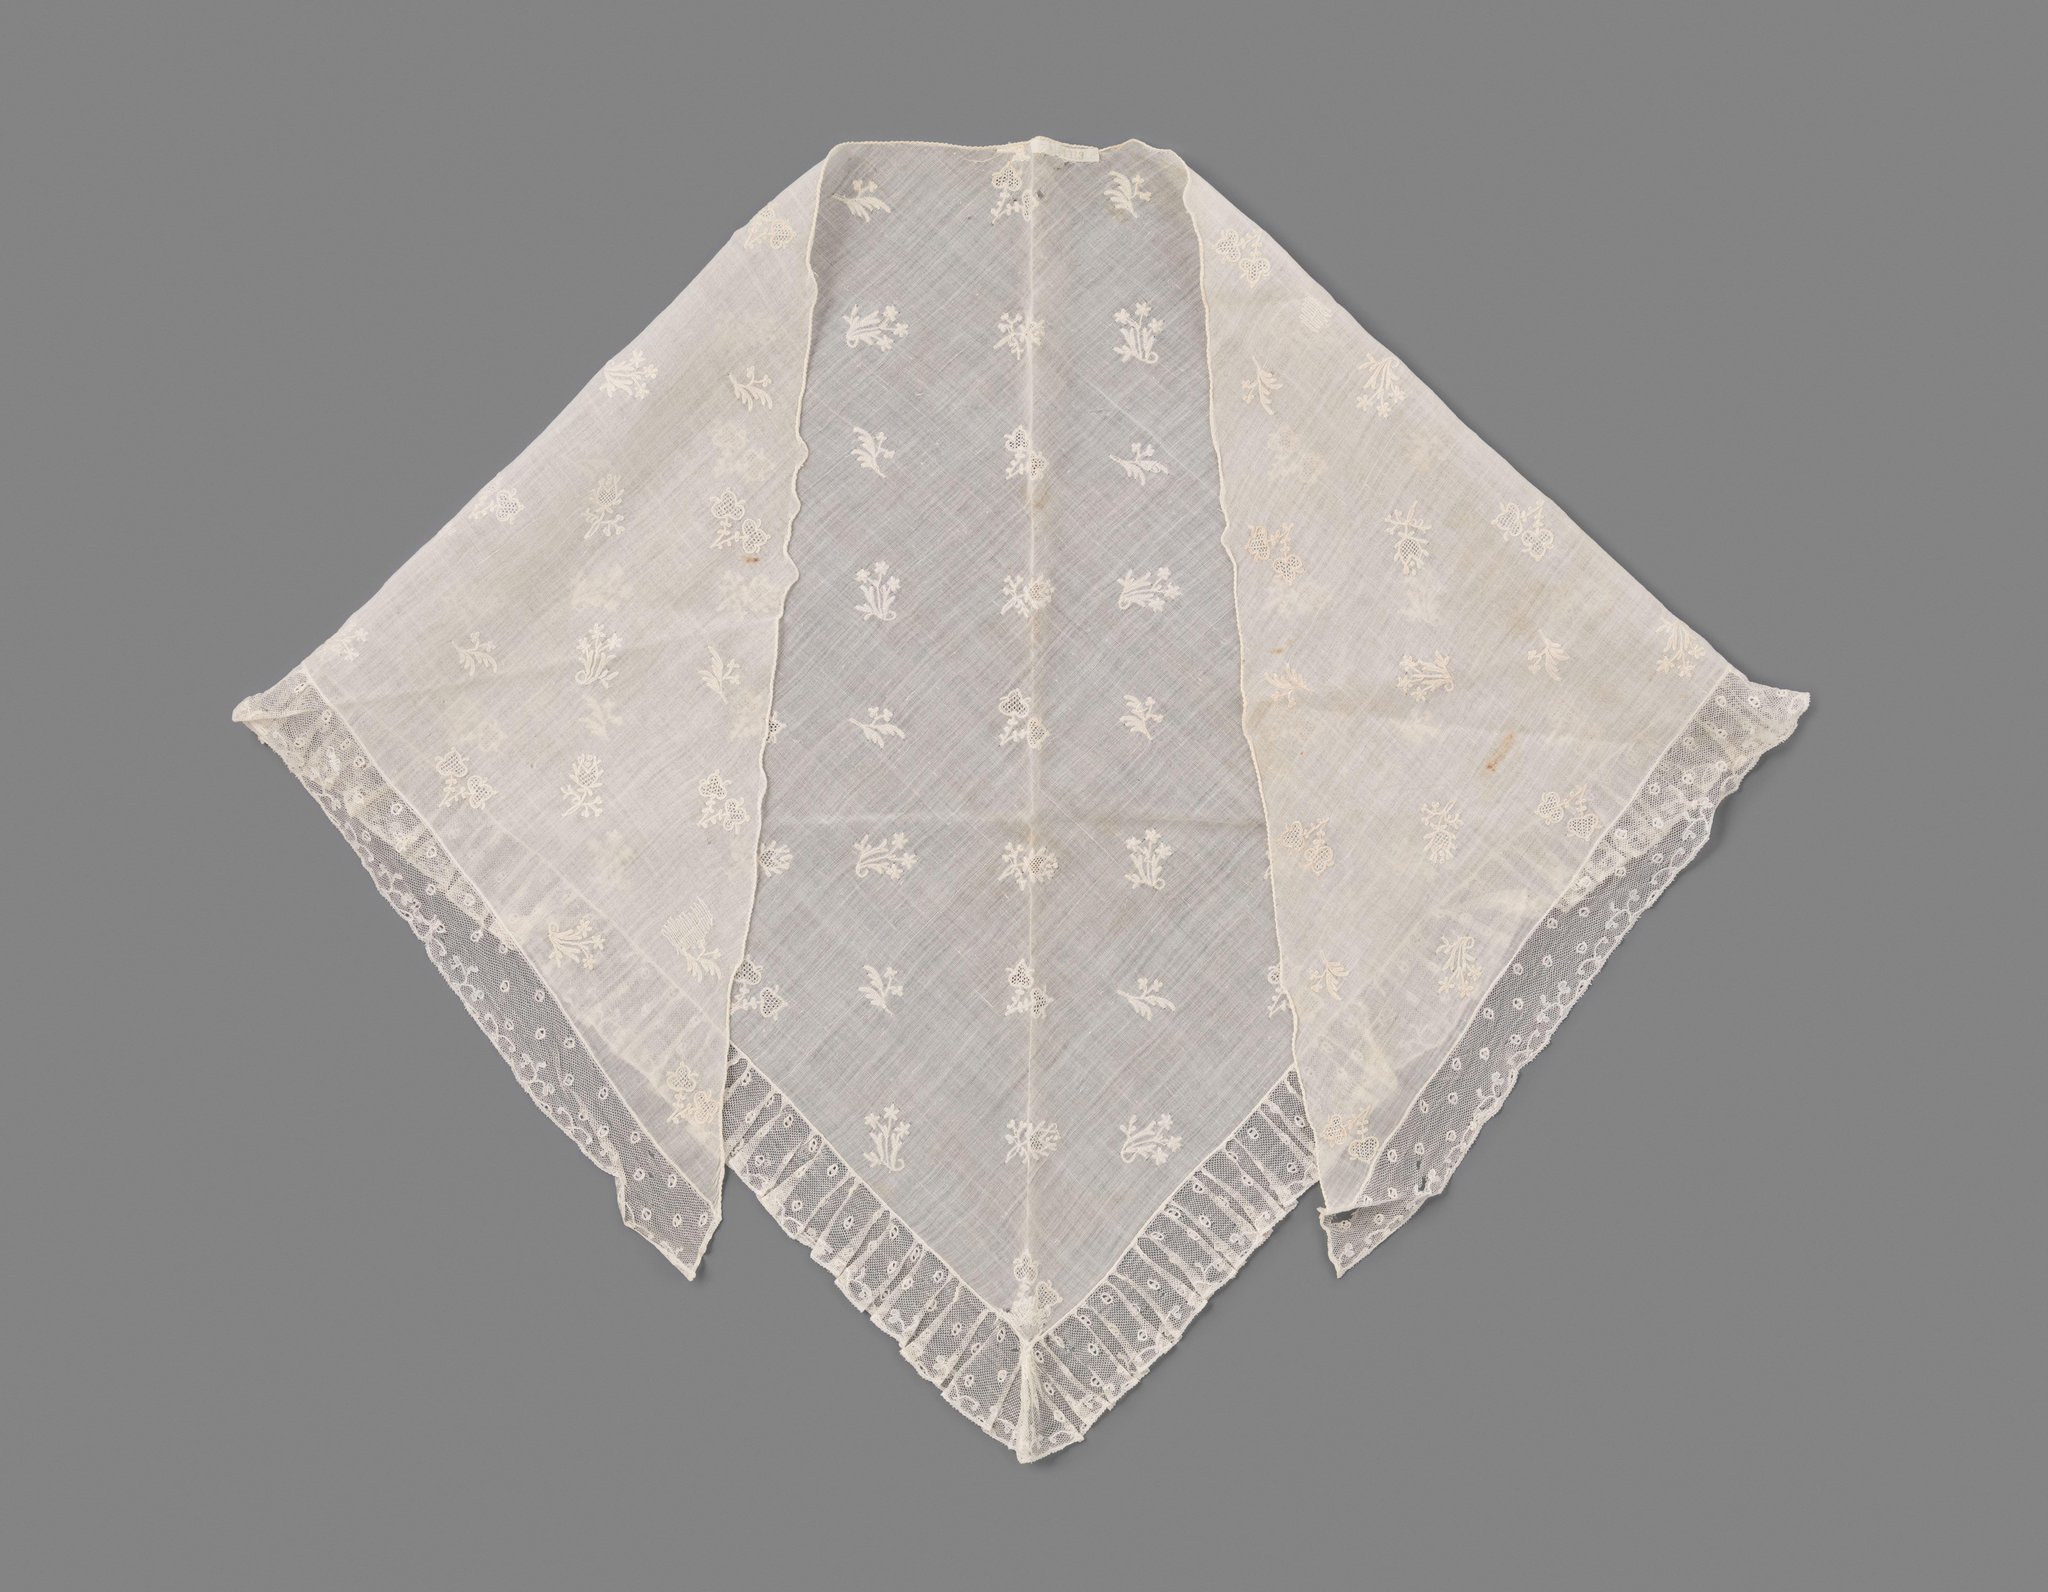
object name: fichu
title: Fichu van linnenbatist, driekantig, getamboereerd met strooiboeketten van katoen en langs twee zijden afgezet met een gedeeltelijk gerimpelde strook Mechelse kant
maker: Anonymous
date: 1775-1800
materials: cotton, linen, silk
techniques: cockled, lace, weave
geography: zaanstreek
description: Fichu van linnenbatist, driekantig, getamboereerd met strooiboeketten van katoen en langs twee zijden afgezet met een gerimpelde strook Mechels kloskant. Versiering: strooimotief van fantasiebloemen en boeketten, waarvan sommige met naaldkant harten. De strook kloskant is voor de helft gerimpeld (op de rug) en waar de fichu aan de voorkant afhangt ongerimpeld. Onderdeel van Zaans kostuum.